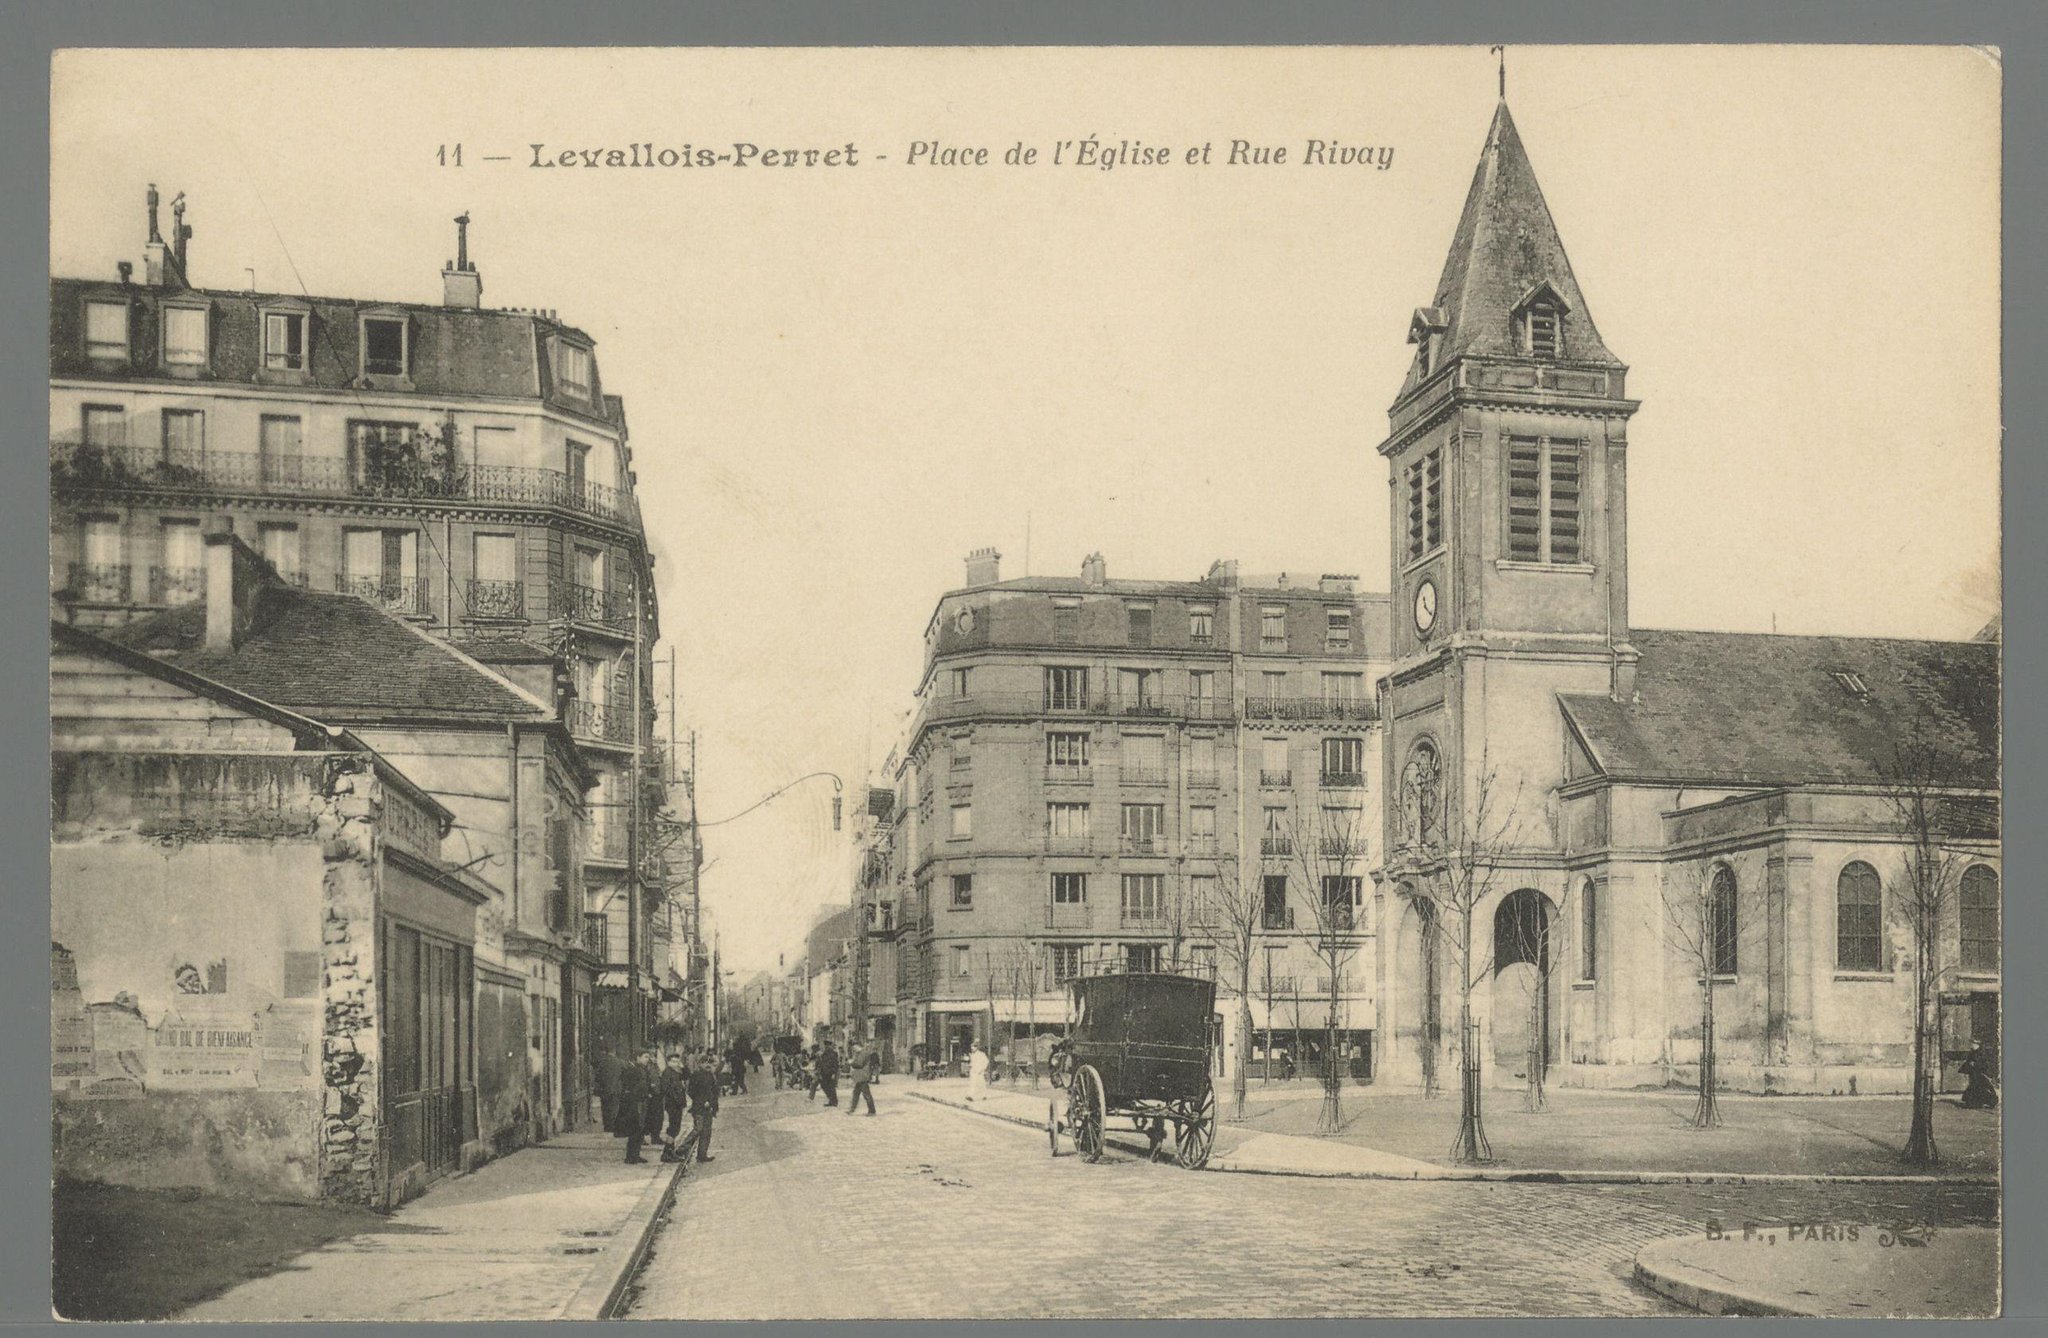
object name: photomechanical print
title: Levallois-Perret. Place de l'Église et Rue Rivay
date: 1904-1906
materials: cardboard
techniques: photograph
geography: paris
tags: church (exterior), city-view, and landscape with man-made constructions (+ city(-scape) with figures, staffage)